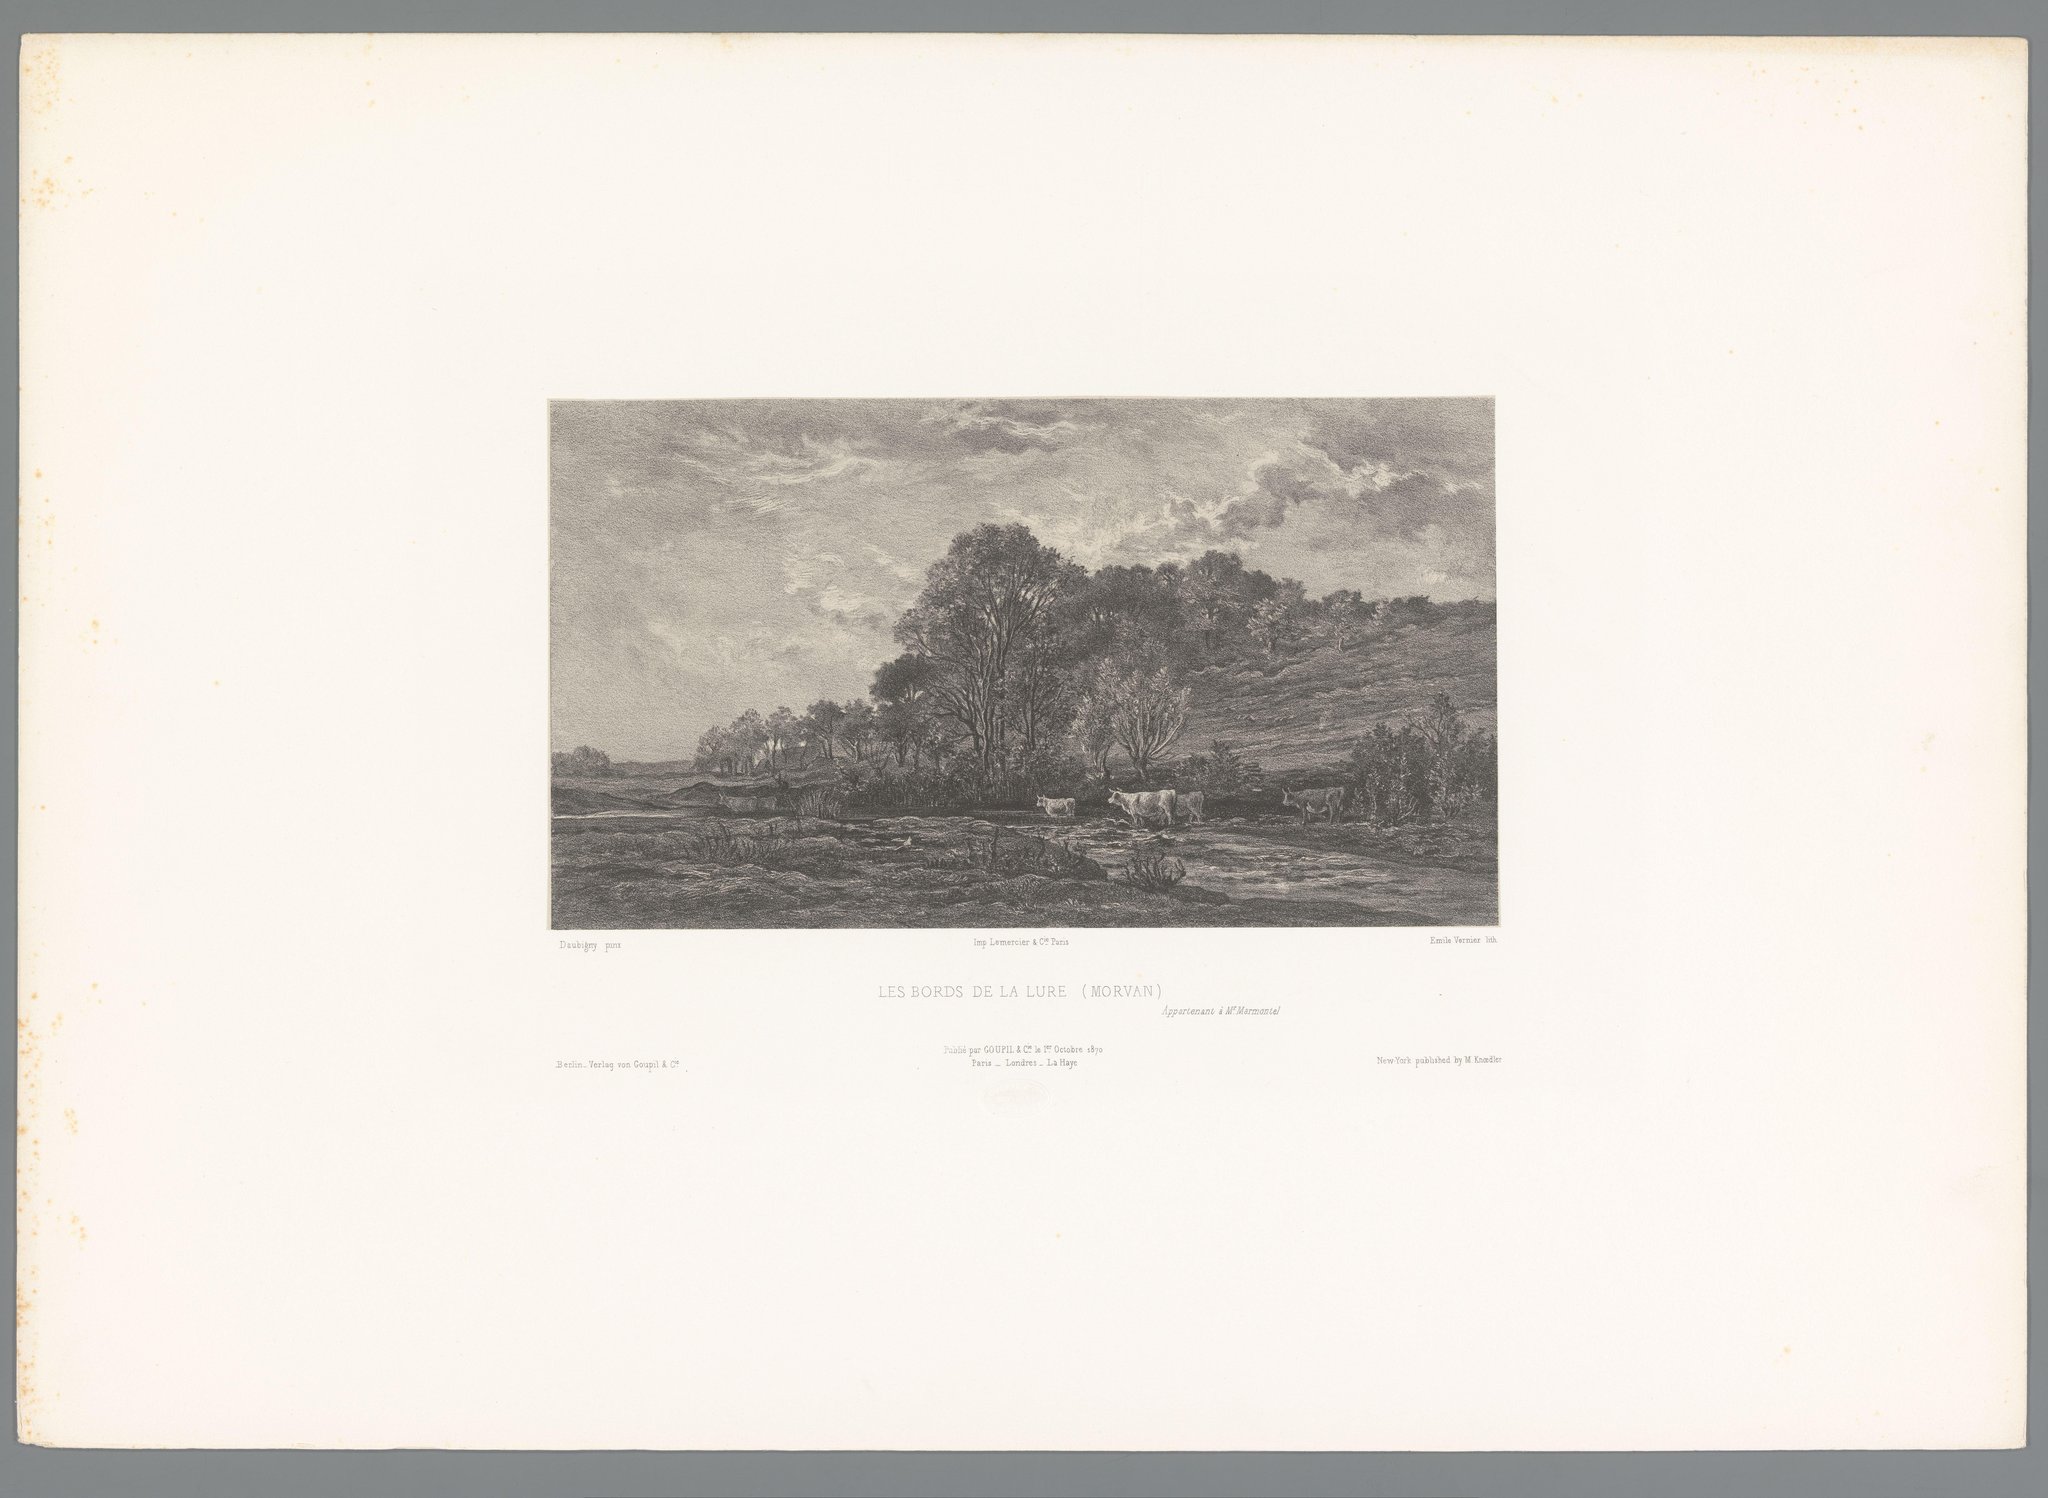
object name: print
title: Twaalf landschappen naar Daubigny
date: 1870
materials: paper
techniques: lithograph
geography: berlin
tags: cow, landscapes with waters, waterscapes, seascapes (in the temperate zone)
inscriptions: collector's mark: Lugt 1090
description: Het volgnummer in de serie is niet vermeld.